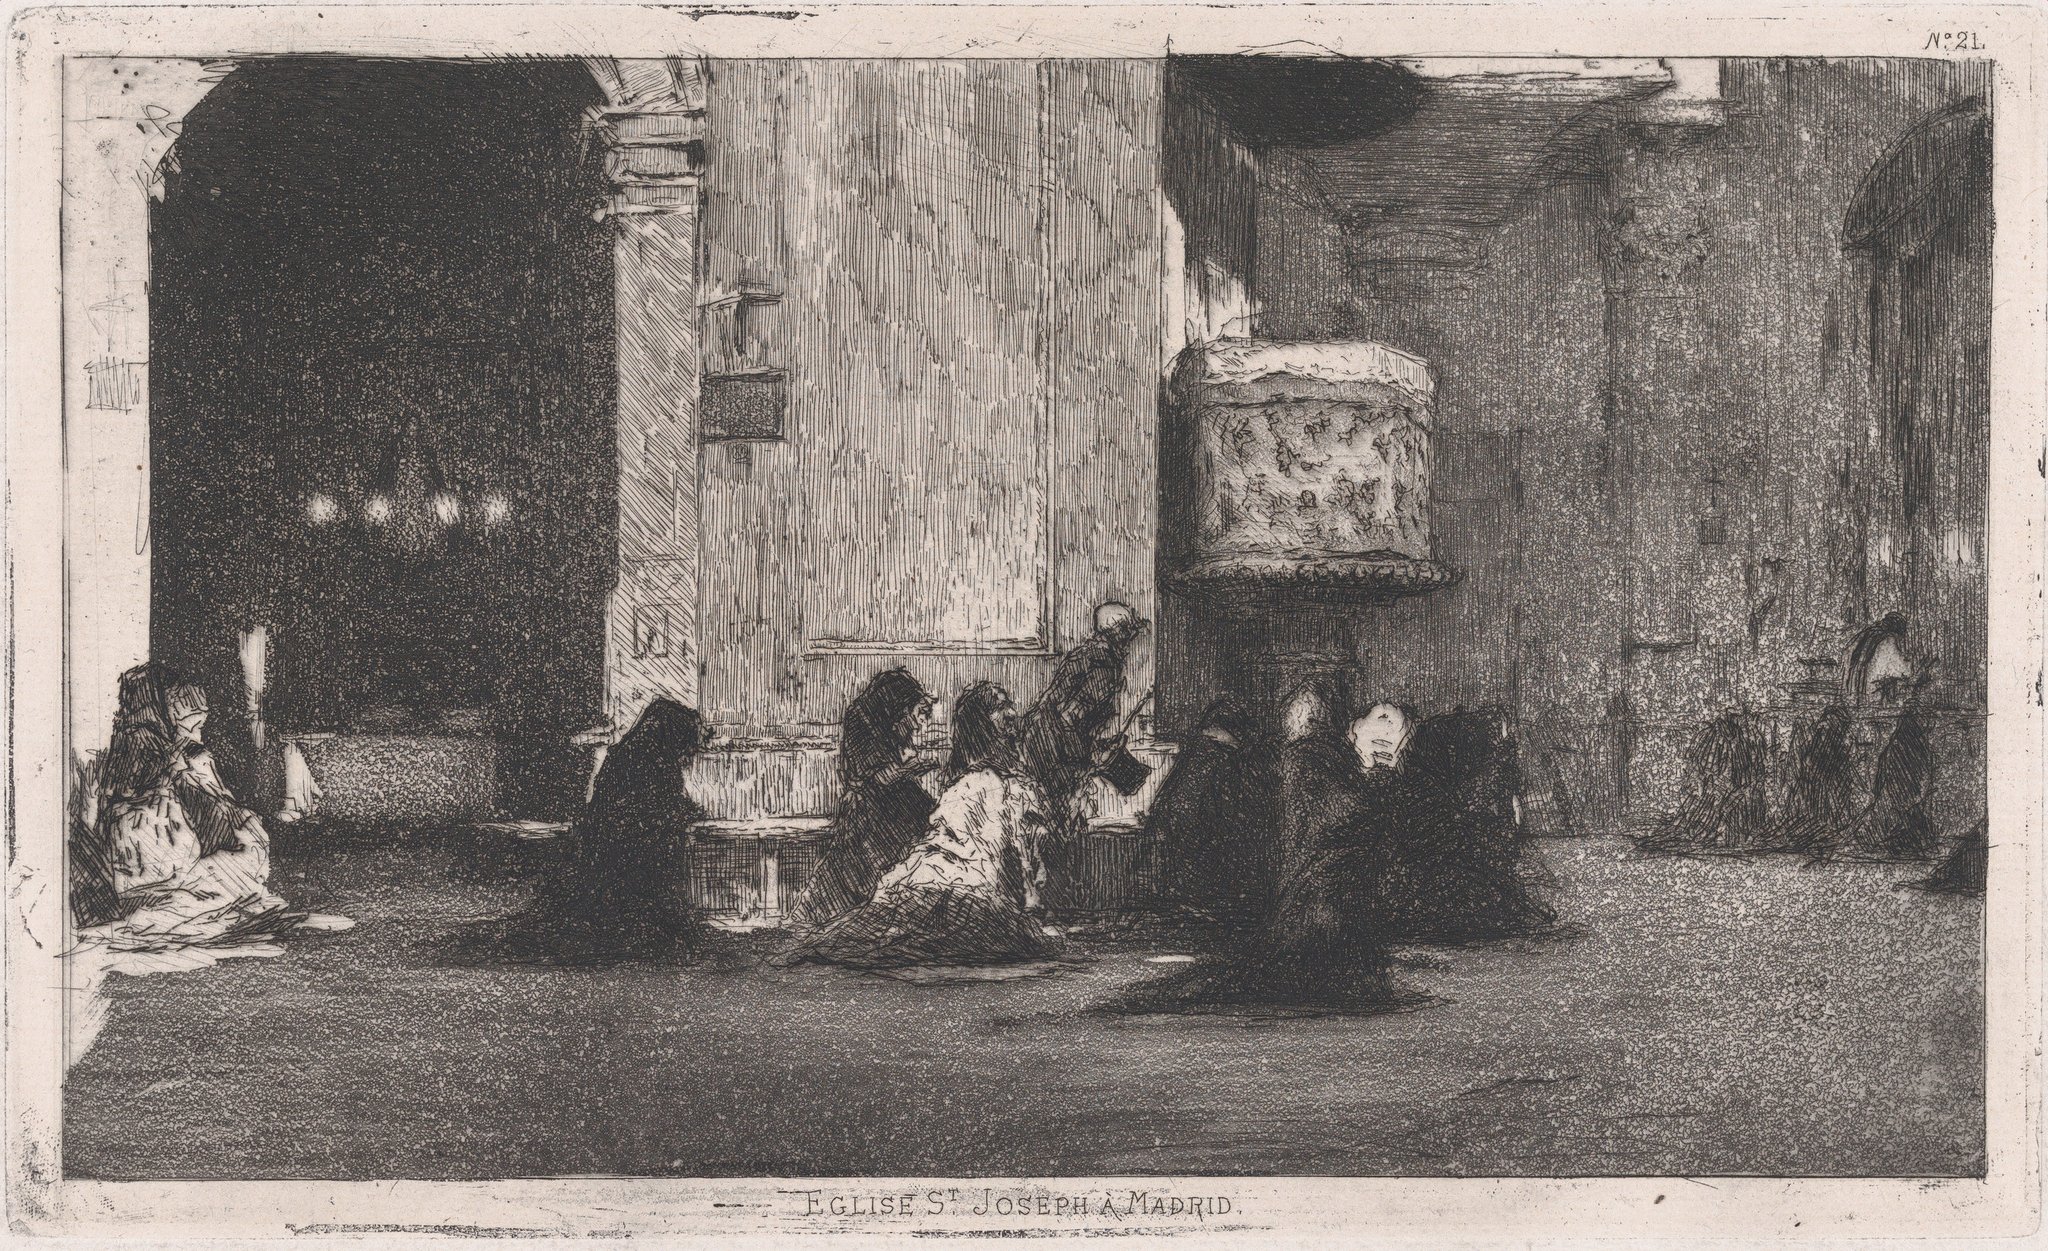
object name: print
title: Entrance to the church of St Joseph (San José), Madrid, figures seated on the ground in front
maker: mariano fortuny, 1838–1874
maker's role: artist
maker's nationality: spanish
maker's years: 1838-1874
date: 1860-1870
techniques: aquatint, etching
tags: human figures,churches